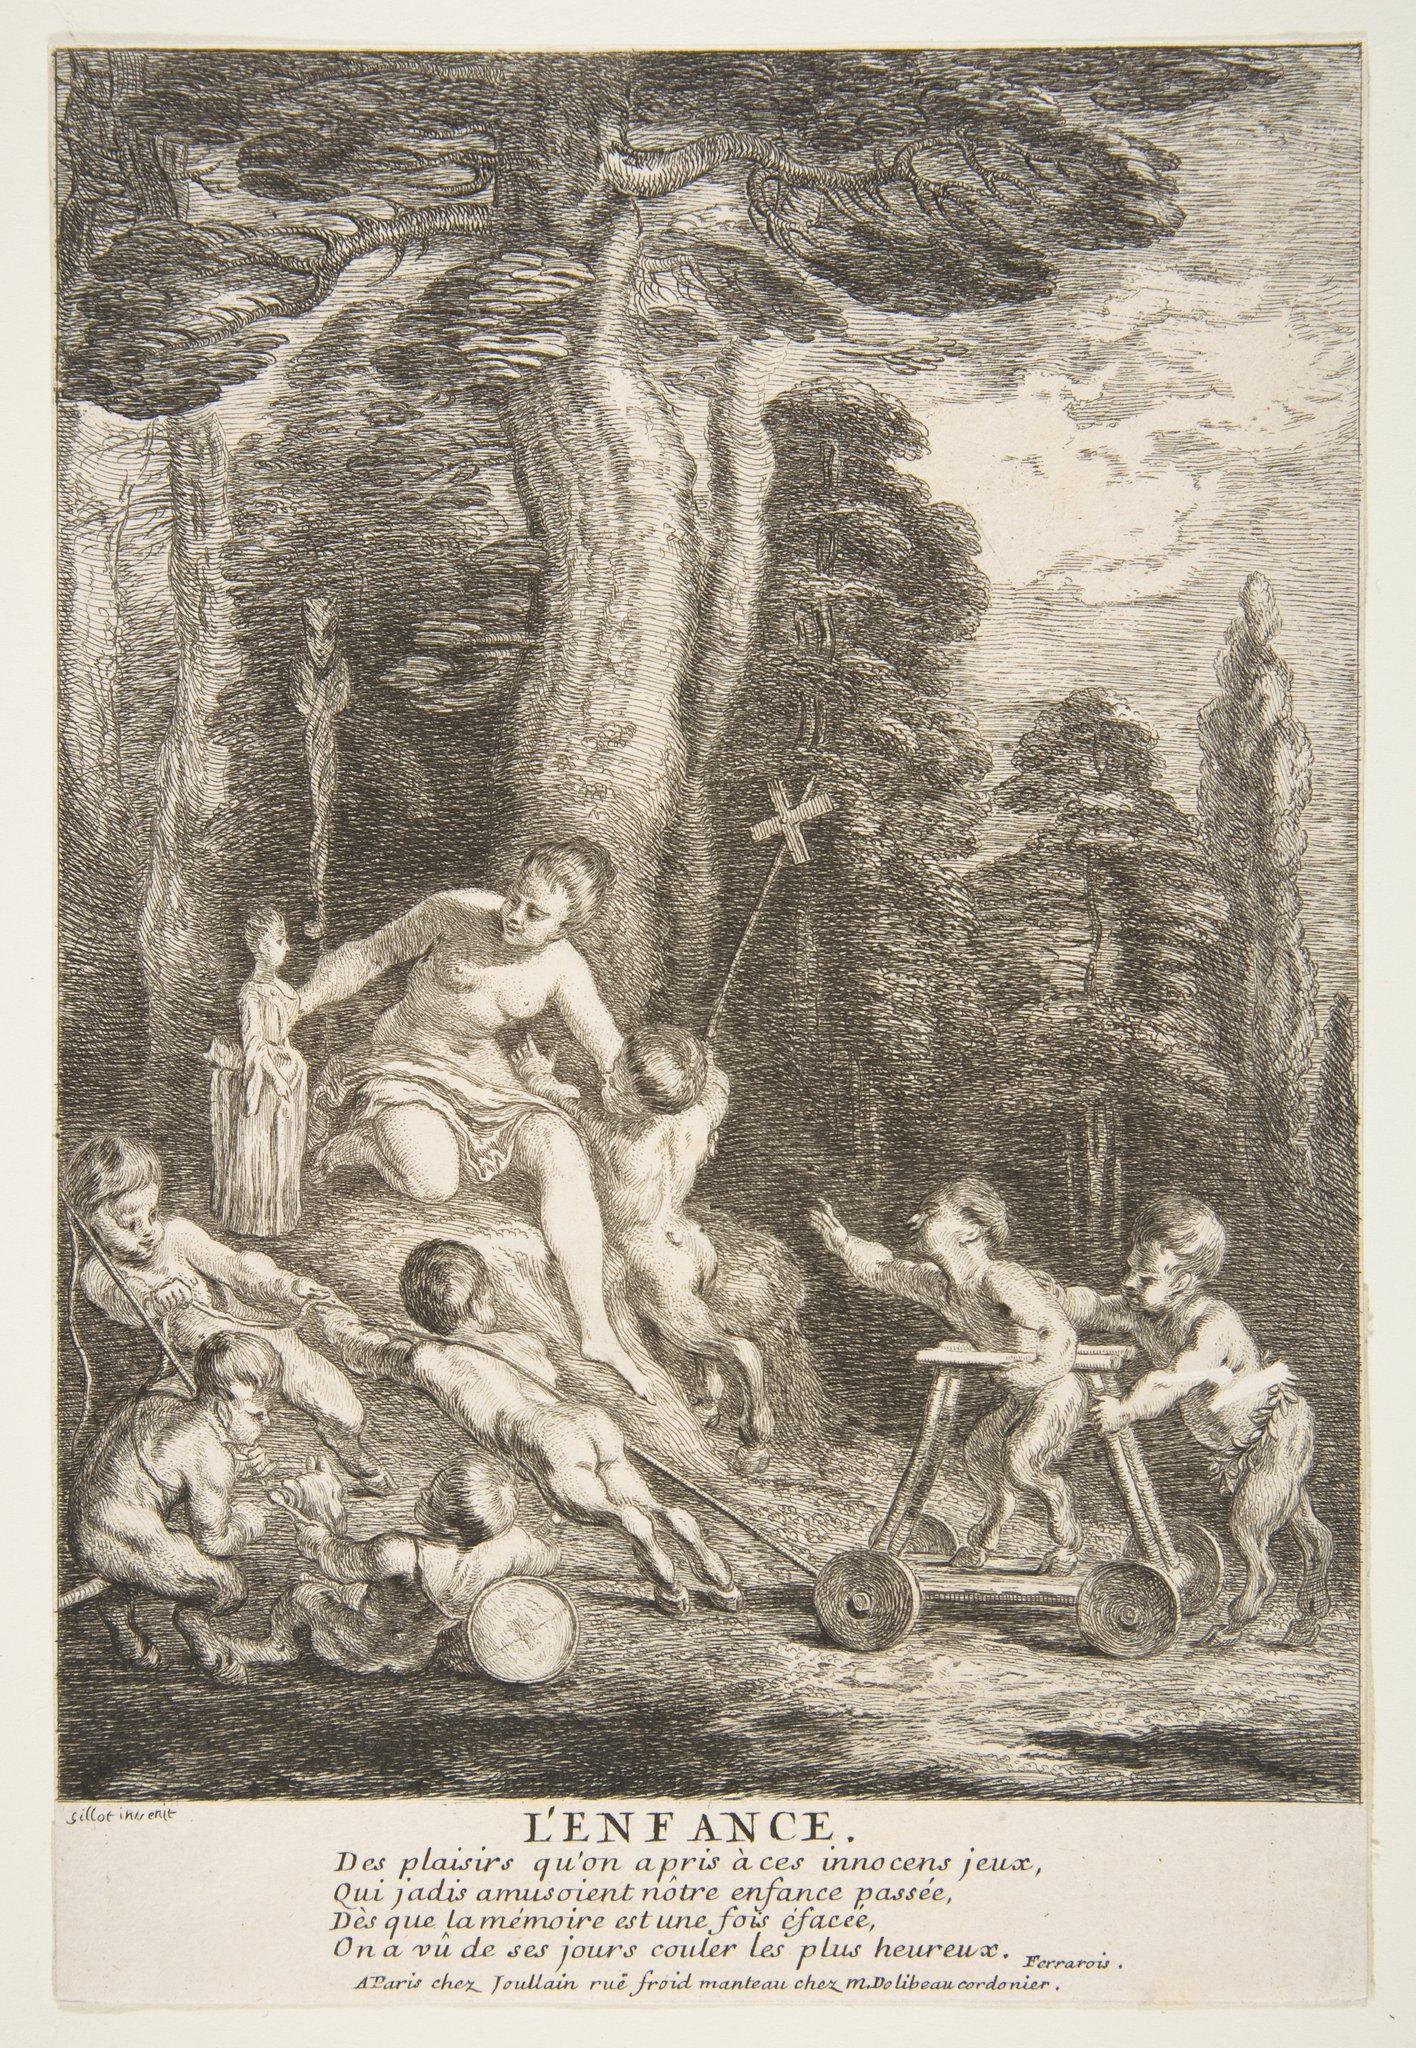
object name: print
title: Adolescence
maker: claude gillot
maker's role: artist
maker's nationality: french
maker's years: 1673-1722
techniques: etching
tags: children,female nudes,playing